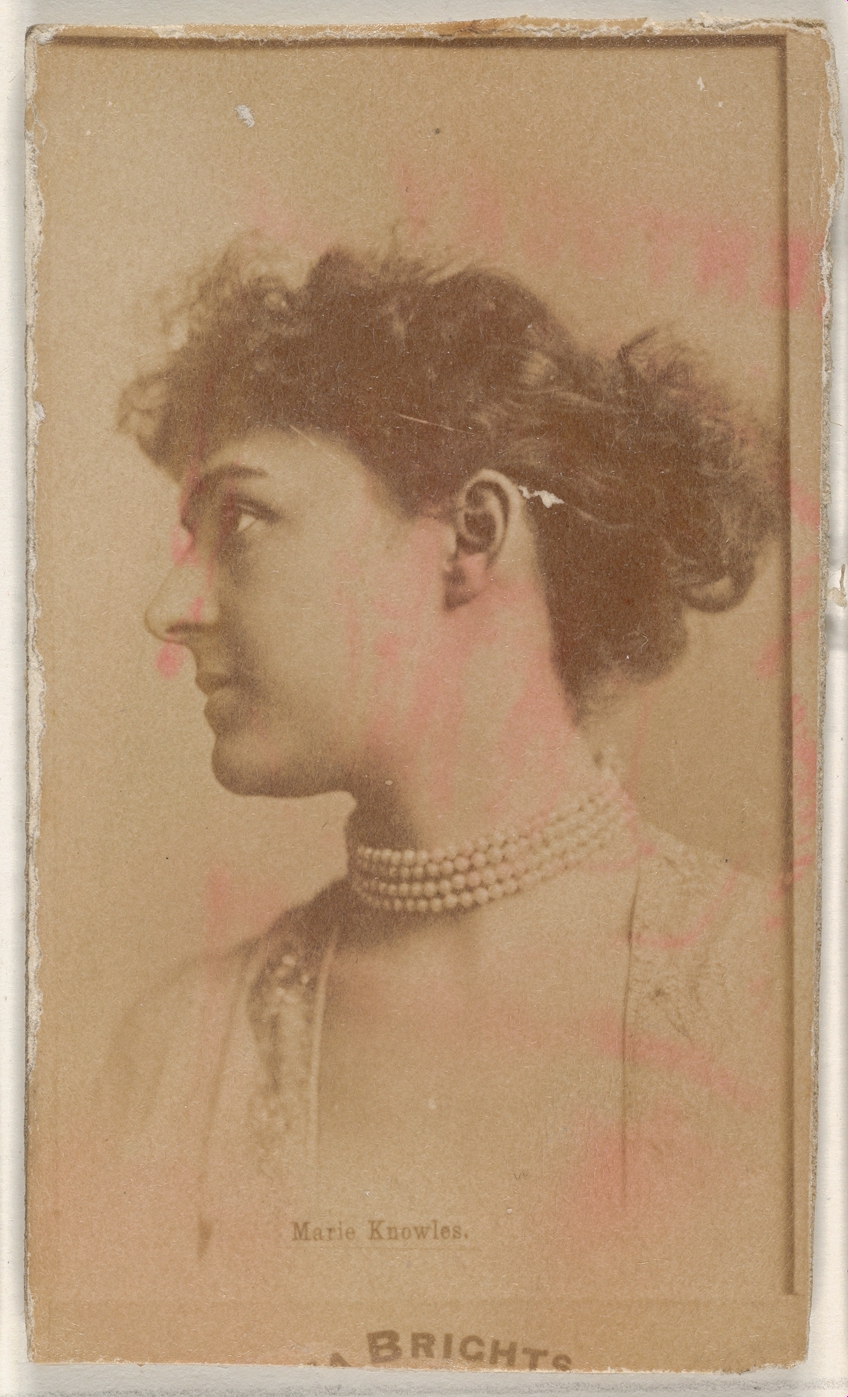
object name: photograph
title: Marie Knowles, from the Actors and Actresses series (N45, Type 1) for Virginia Brights Cigarettes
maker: allen & ginter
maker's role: publisher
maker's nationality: american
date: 1888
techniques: albumen silver print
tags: portraits,women,actresses